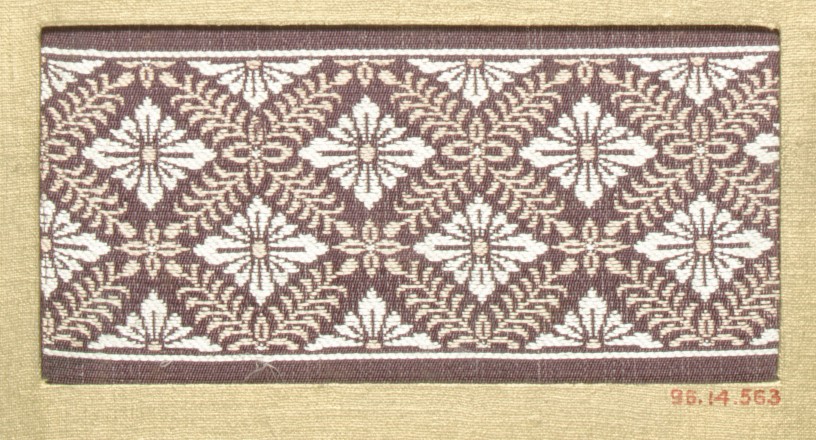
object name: piece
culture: japanese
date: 1701-1900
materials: silk